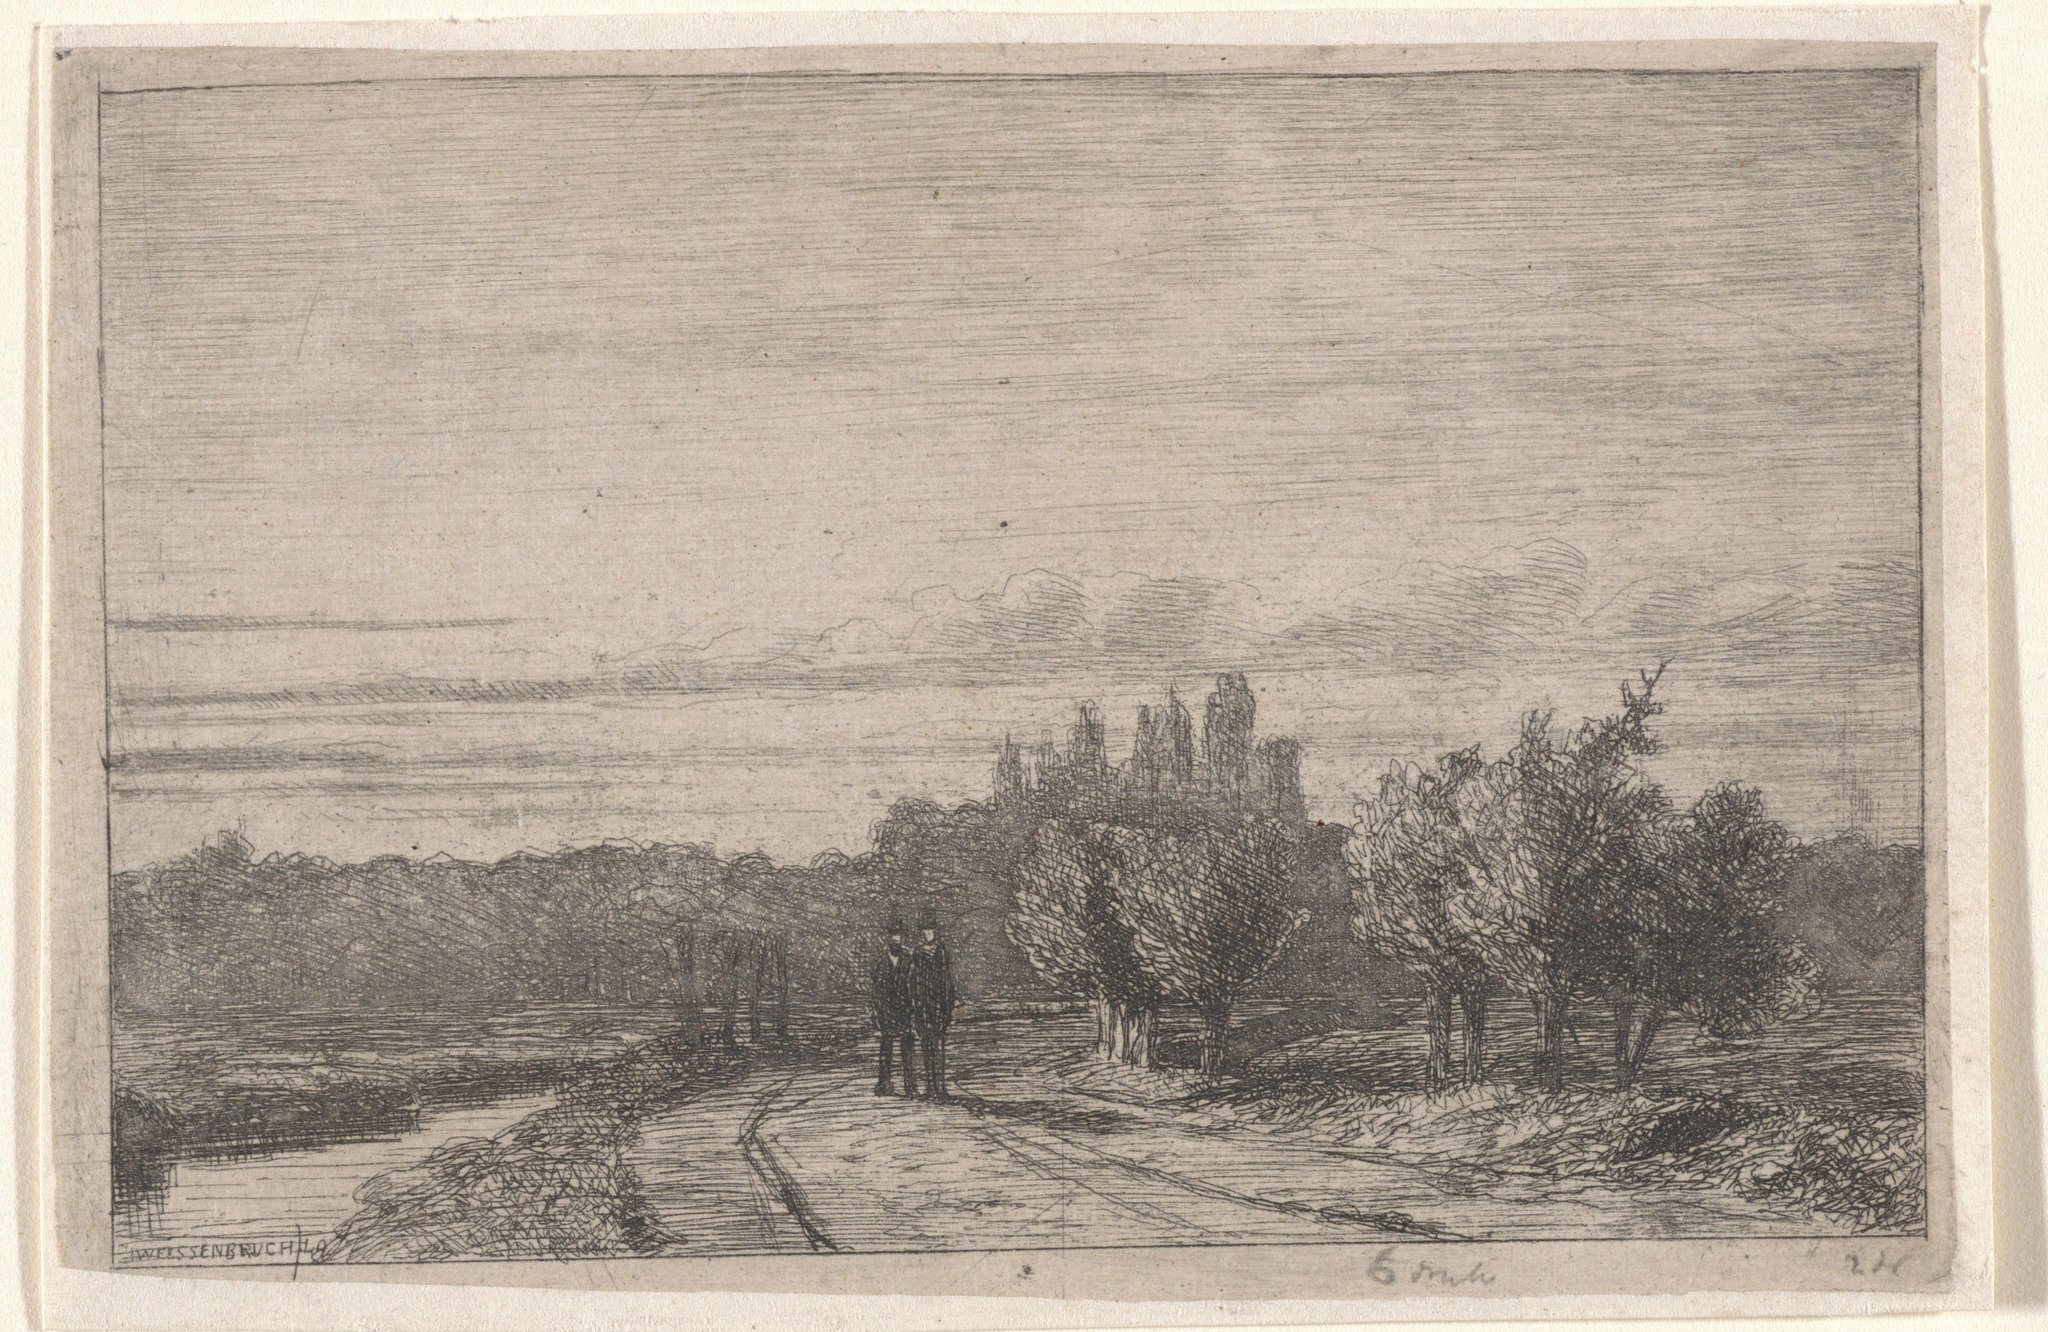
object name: print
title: Gezicht op de Schenkweg vanaf de Koepel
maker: jan weissenbruch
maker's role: painter, print maker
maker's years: 1822-1880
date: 1849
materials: paper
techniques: etching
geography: the hague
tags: trees, landscapes, adult man, road, path, brook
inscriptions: collector's mark: Lugt 2228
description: Twee mannen, mogelijk leden van de Haagsche Etsclub, staan op de Haagse Schenkweg. Links stroomt een beek en rechts zijn enkele bomen te zien.